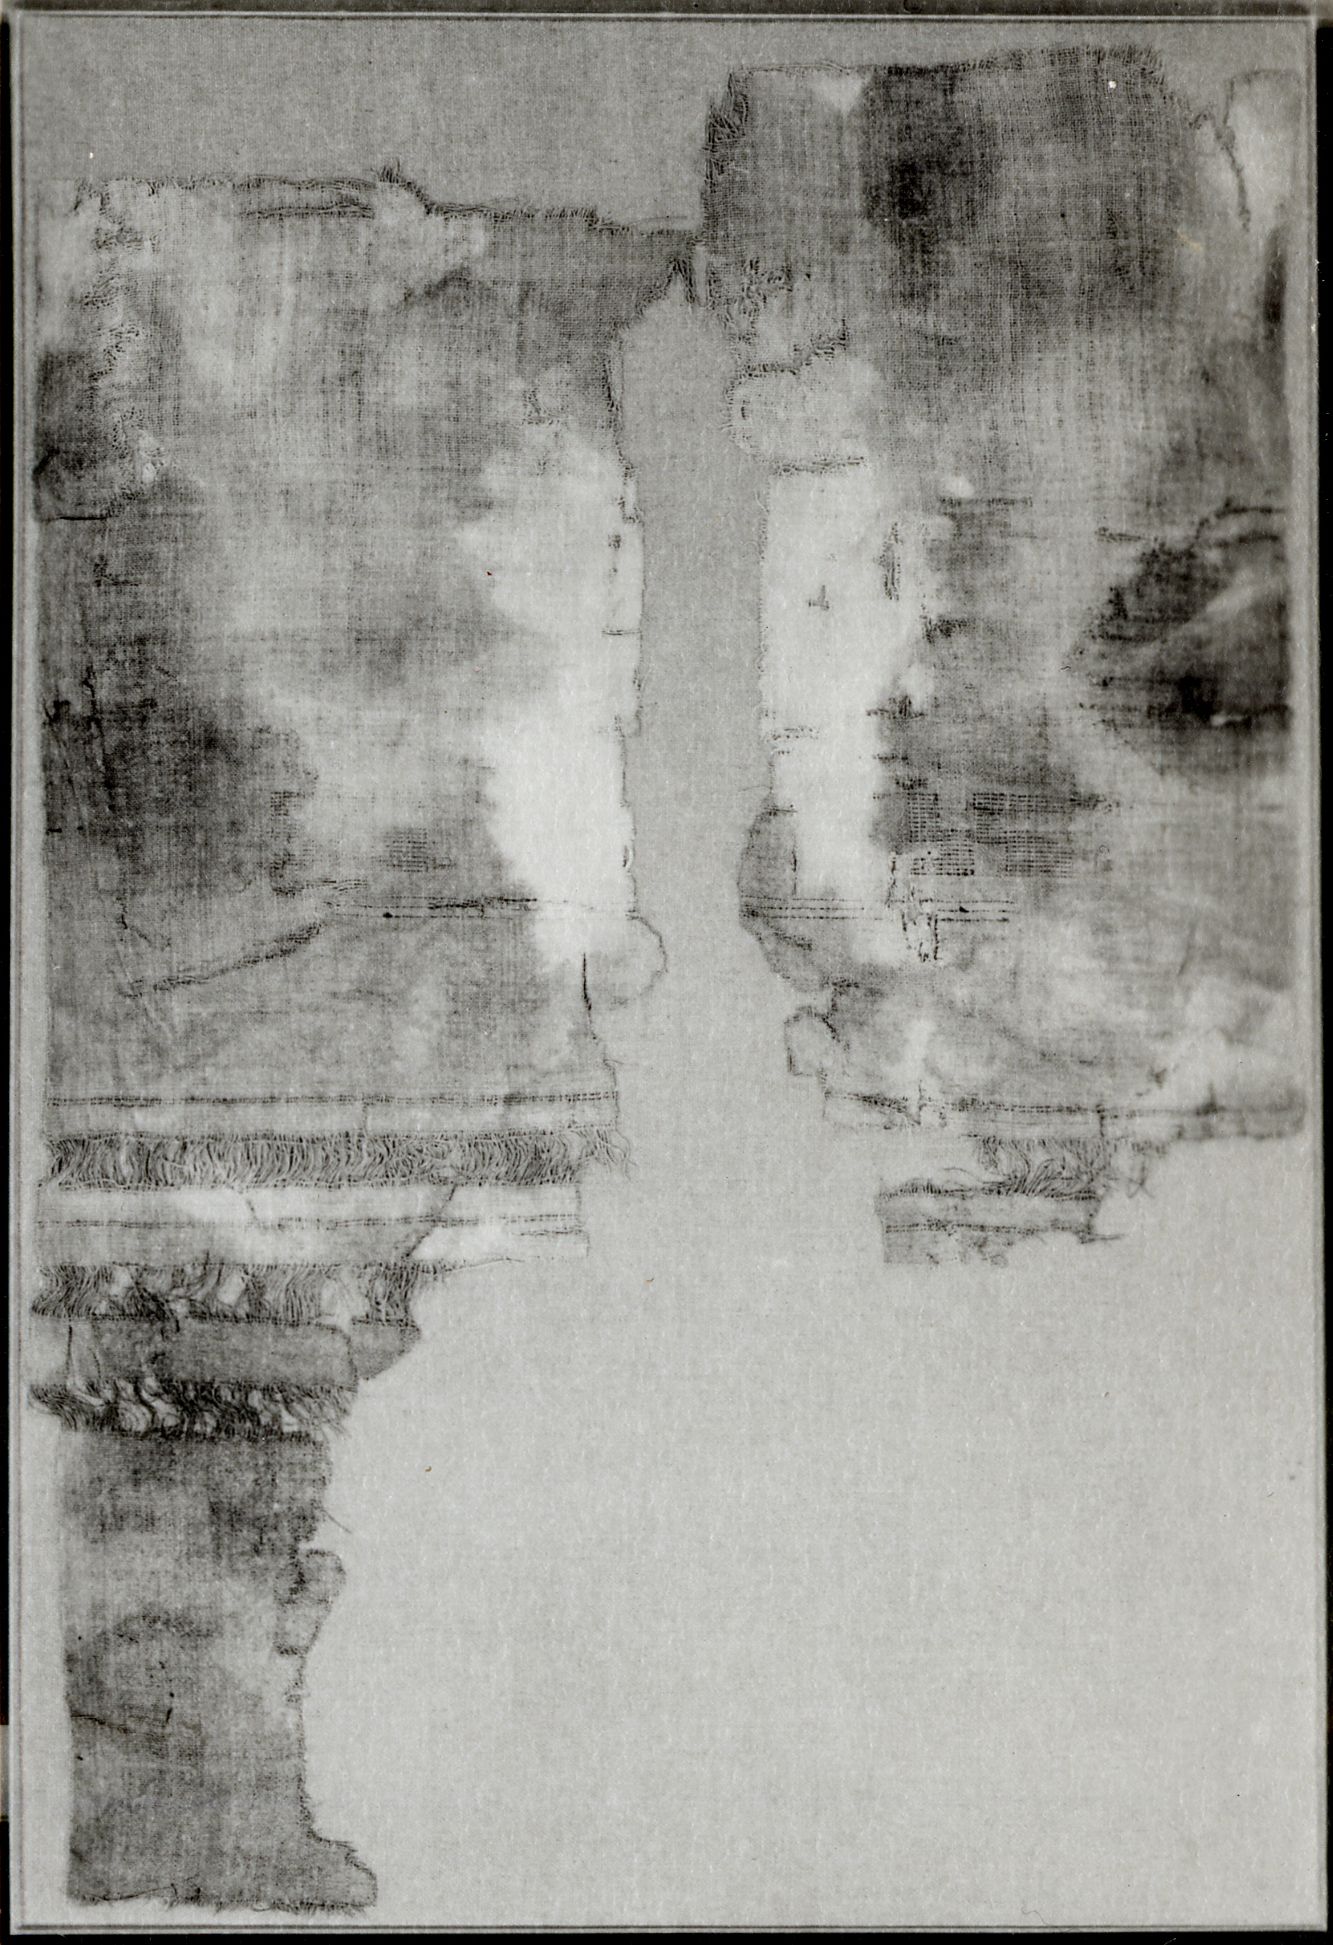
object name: fragment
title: Sheet Fragment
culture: coptic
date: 301-400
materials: linen, wool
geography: egypt